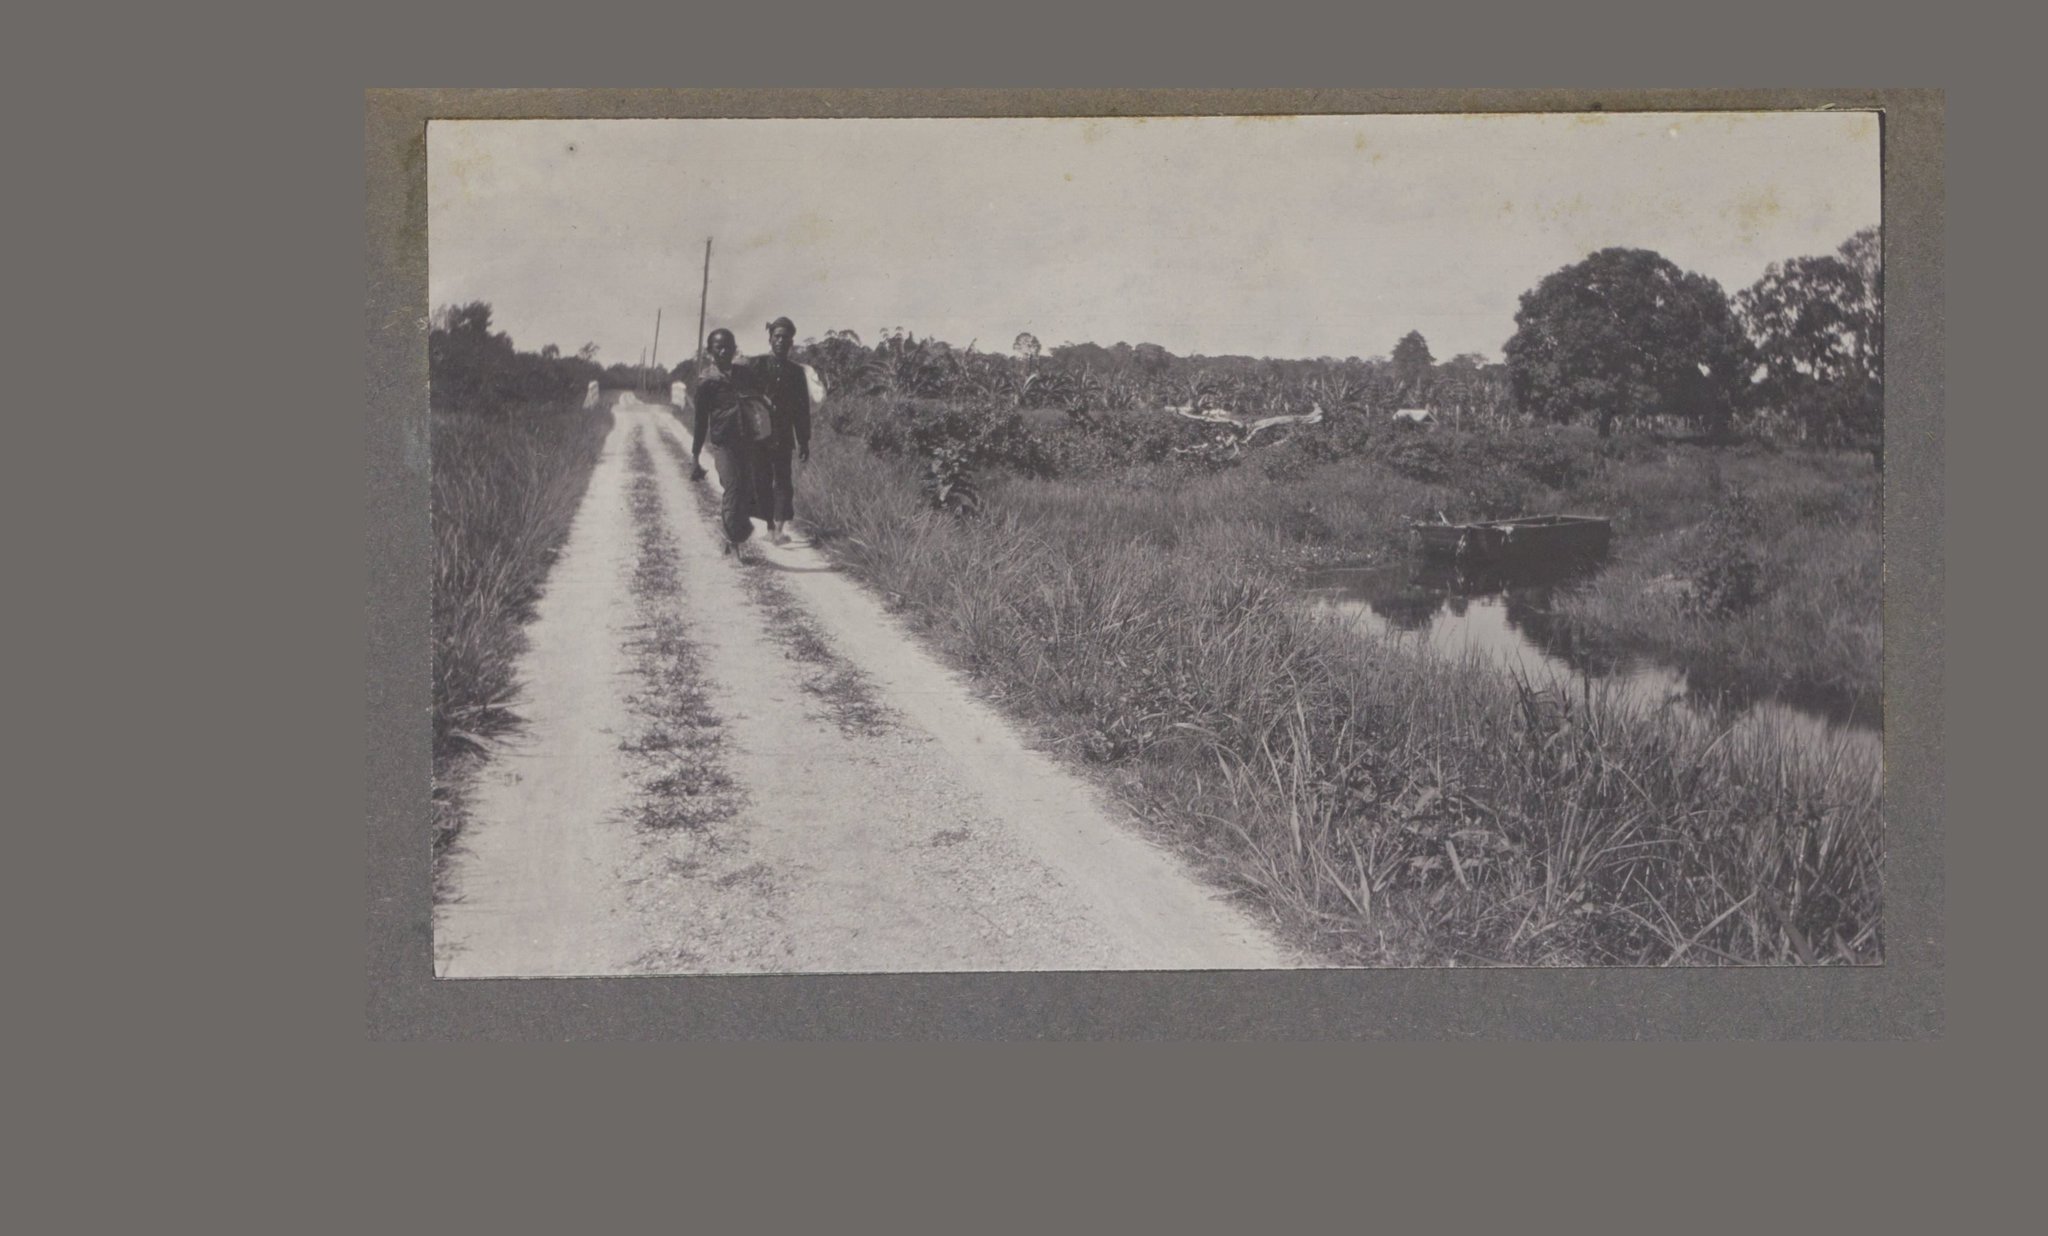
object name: photograph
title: Twee Hindostanen op een weg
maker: andries augustus boom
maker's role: amateurfotograaf, handelaar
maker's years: 1878-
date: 1911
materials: photographic support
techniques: photography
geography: suriname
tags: suriname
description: Twee Hindostanen, man en vrouw, lopend over een landweg, 1911. Onderweg naar Plantage Morgenstond. Onderdeel van het fotoalbum over het leven van de familie Gonggrijp in Suriname rond 1912.